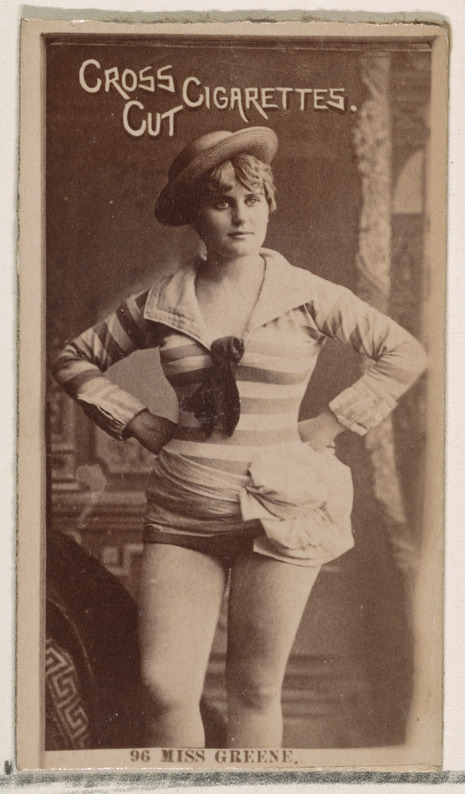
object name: print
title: Card Number 96, Miss Greene, from the Actors and Actresses series (N145-2) issued by Duke Sons & Co. to promote Cross Cut Cigarettes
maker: w. duke, sons & co.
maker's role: publisher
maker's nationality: american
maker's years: 1870-1920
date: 1880-1889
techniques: albumen silver print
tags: portraits,women,actresses